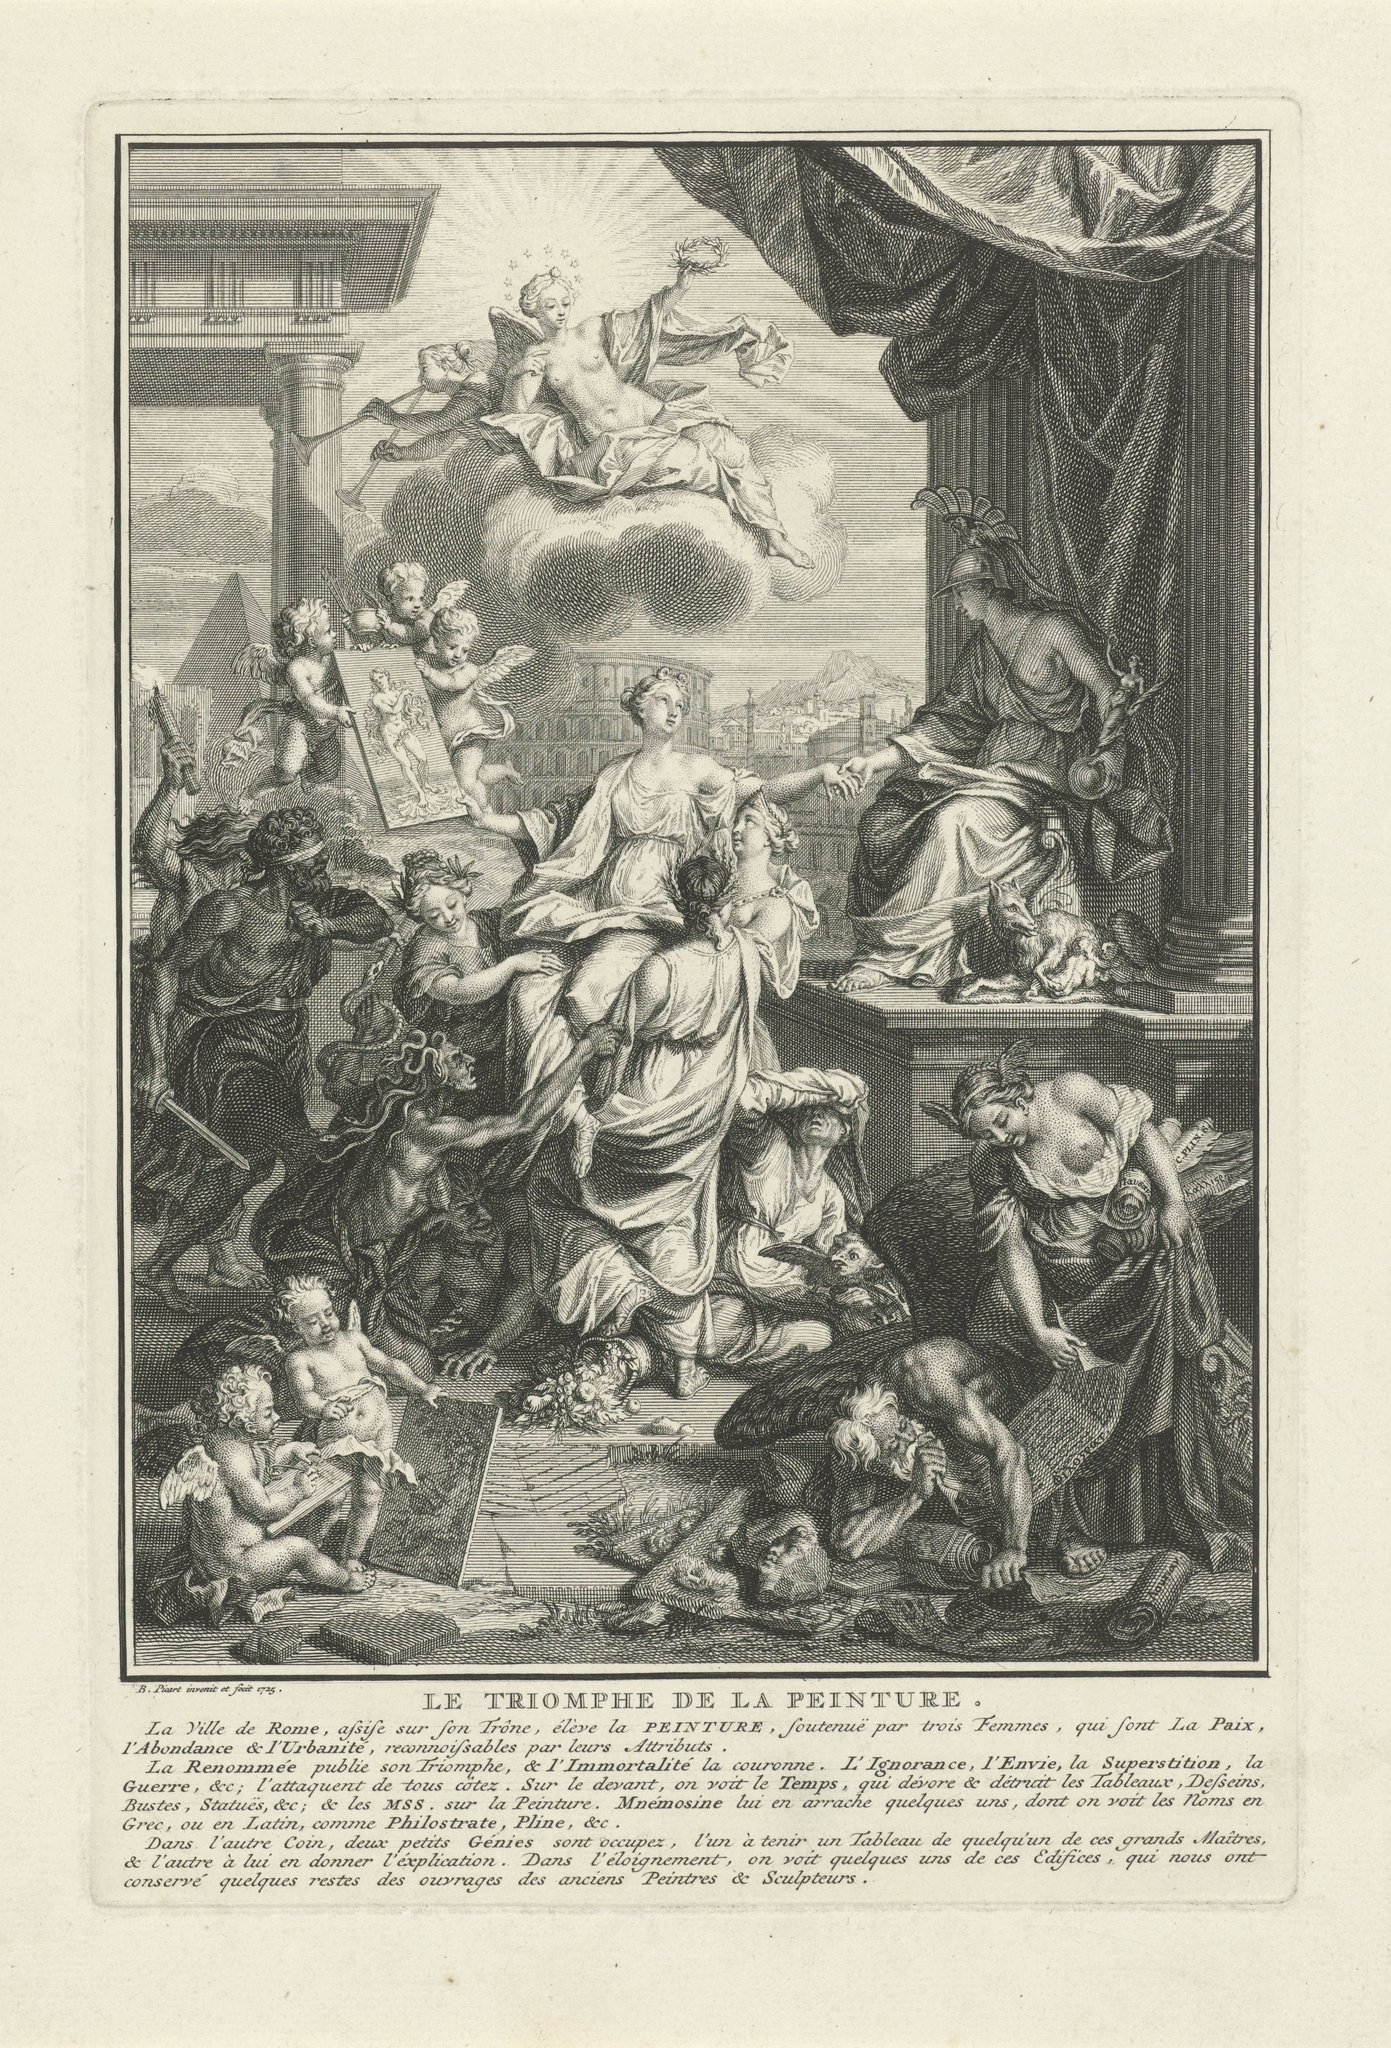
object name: print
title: Le triomphe de la peinture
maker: bernard picart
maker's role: draughtsman, print maker, publisher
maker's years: 1673-1733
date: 1725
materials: paper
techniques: engraving, etching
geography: amsterdam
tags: mnemosyne, 'pictura', symbolic representations, allegories and emblems ~ painting; 'pittura' (ripa), symbols, allegories of peace, 'pax'; 'pace' (ripa), personification of a city, town-patron(ess), triumphs (allegorical and symbolic), eternity, 'aeternitas'; 'eternità','eternità o perpetuità' (ripa), abundance; 'abondanza', 'abondanza maritima' (ripa), father time, man with wings and scythe, rome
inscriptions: collector's mark: Lugt 2228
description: Allegorische titelpagina met Vrede (Pax), Overvloed (Abundantia) en Urbaniteit die de Schilderkunst naar de personificatie van Rome dragen. Onwetendheid (Ignorantia), Afgunst (Invidia) en Bijgeloof (Idolatria) proberen hen tegen te houden. Rechts op de voorgrond Mnemosyne, de godin van het geheugen, die teksten uit de handen van Vader Tijd trekt. In de lucht op een wolk Eeuwigheid met een lauwerkrans in de hand. Op de achtergrond een gezicht op Rome. In de marge een negenregelig onderschrift in het Frans.